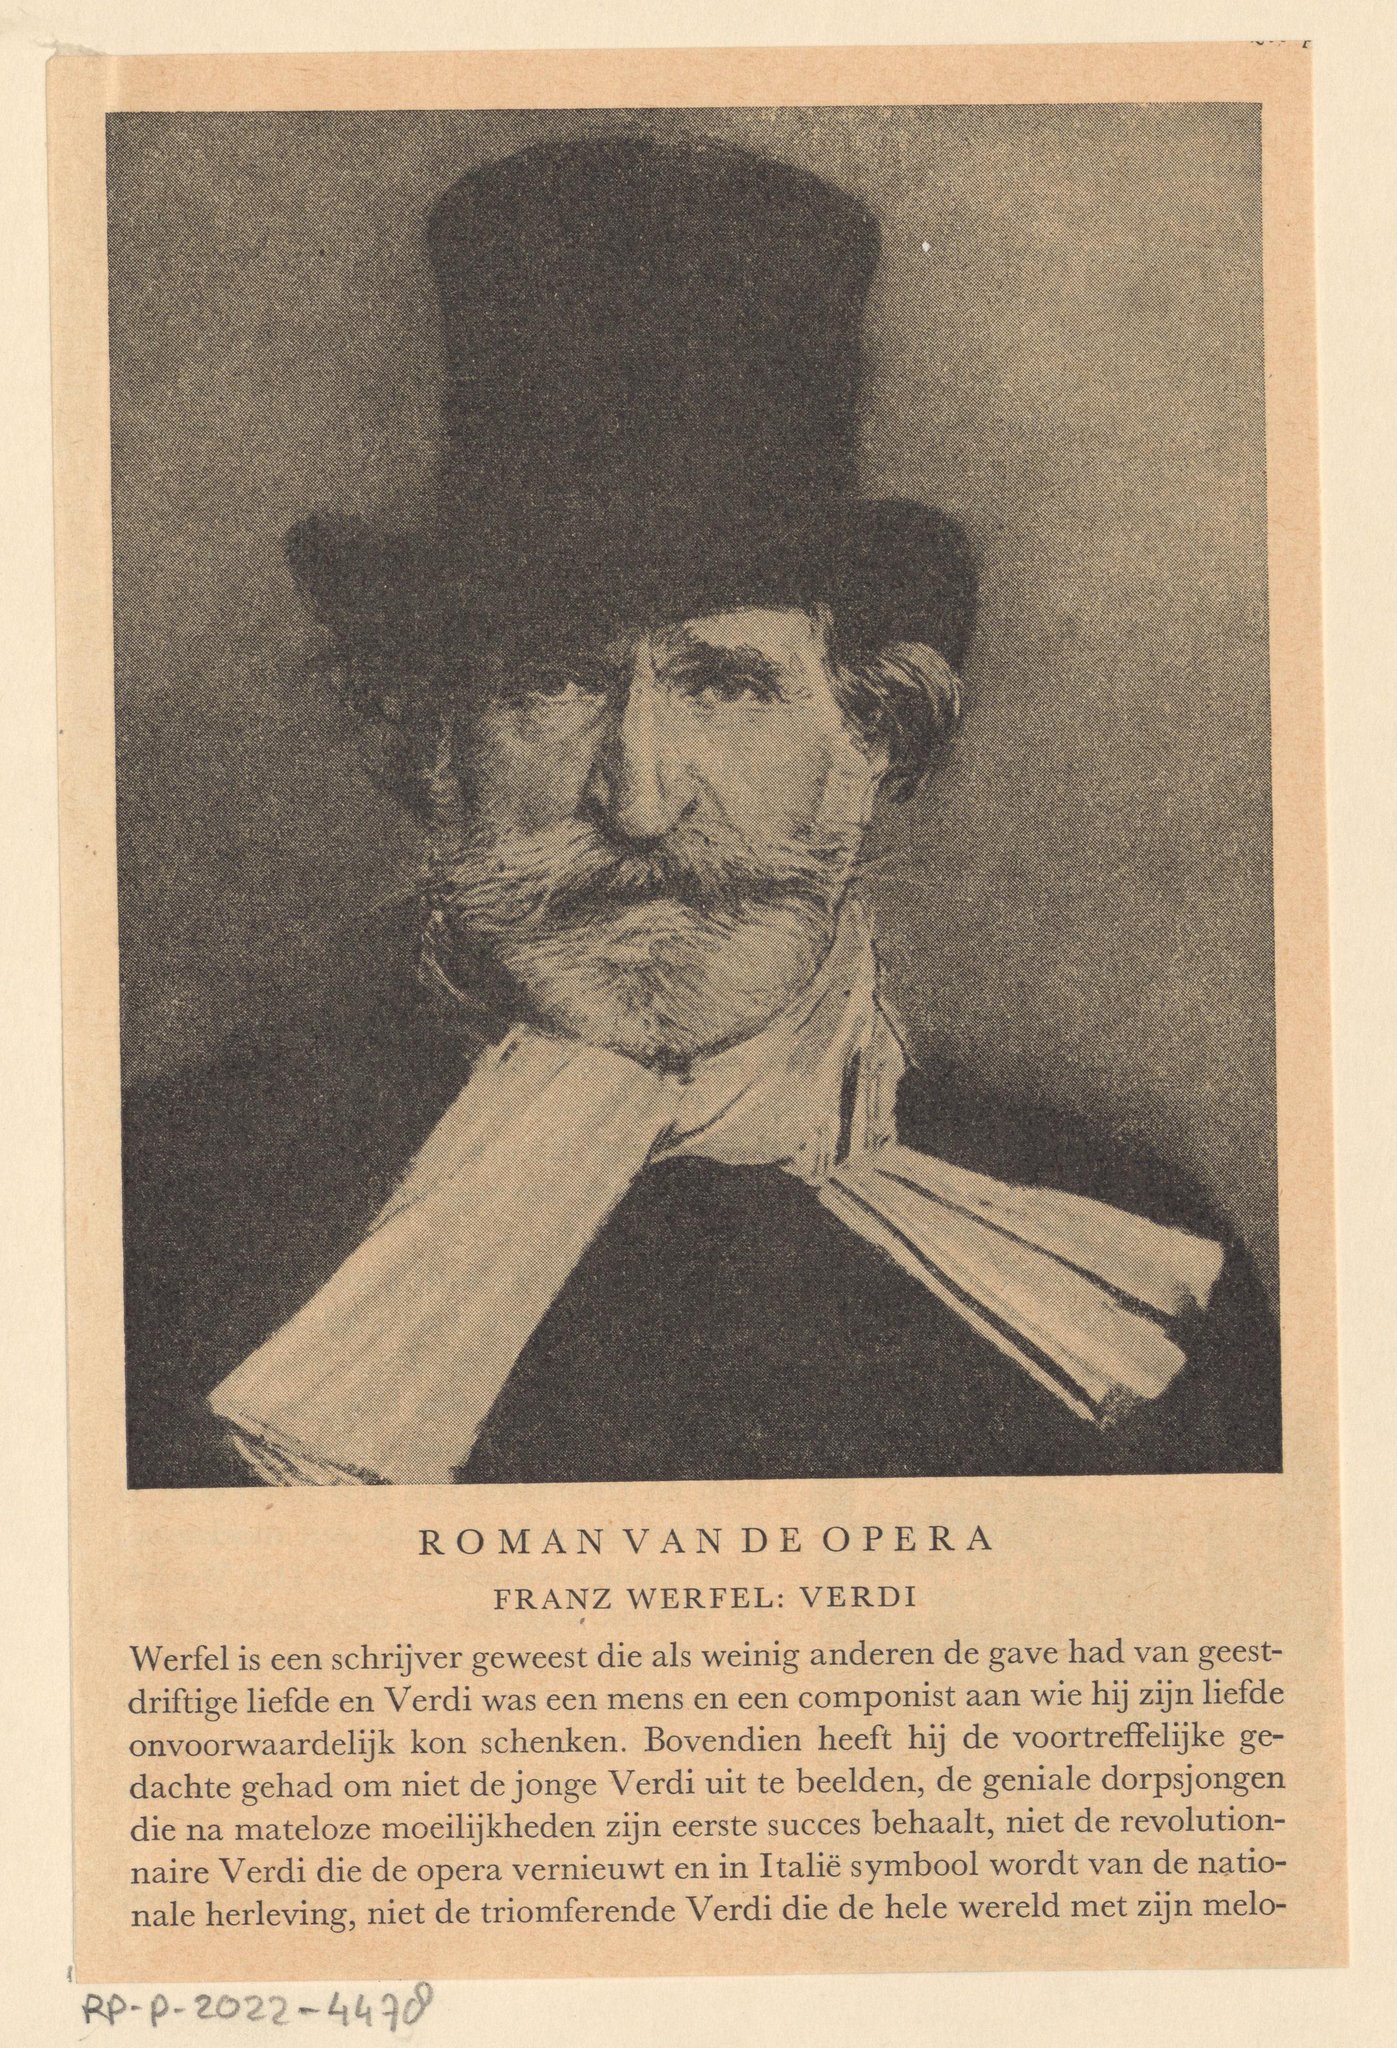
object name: photomechanical print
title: Portret van Guiseppe Verdi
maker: Anonymous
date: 1923-1970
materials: paper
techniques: letterpress printing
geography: italy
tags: guiseppe verdi, historical persons, portrait of opera-singer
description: Fotomechanische afdruk komt uit een onbekende publicatie.